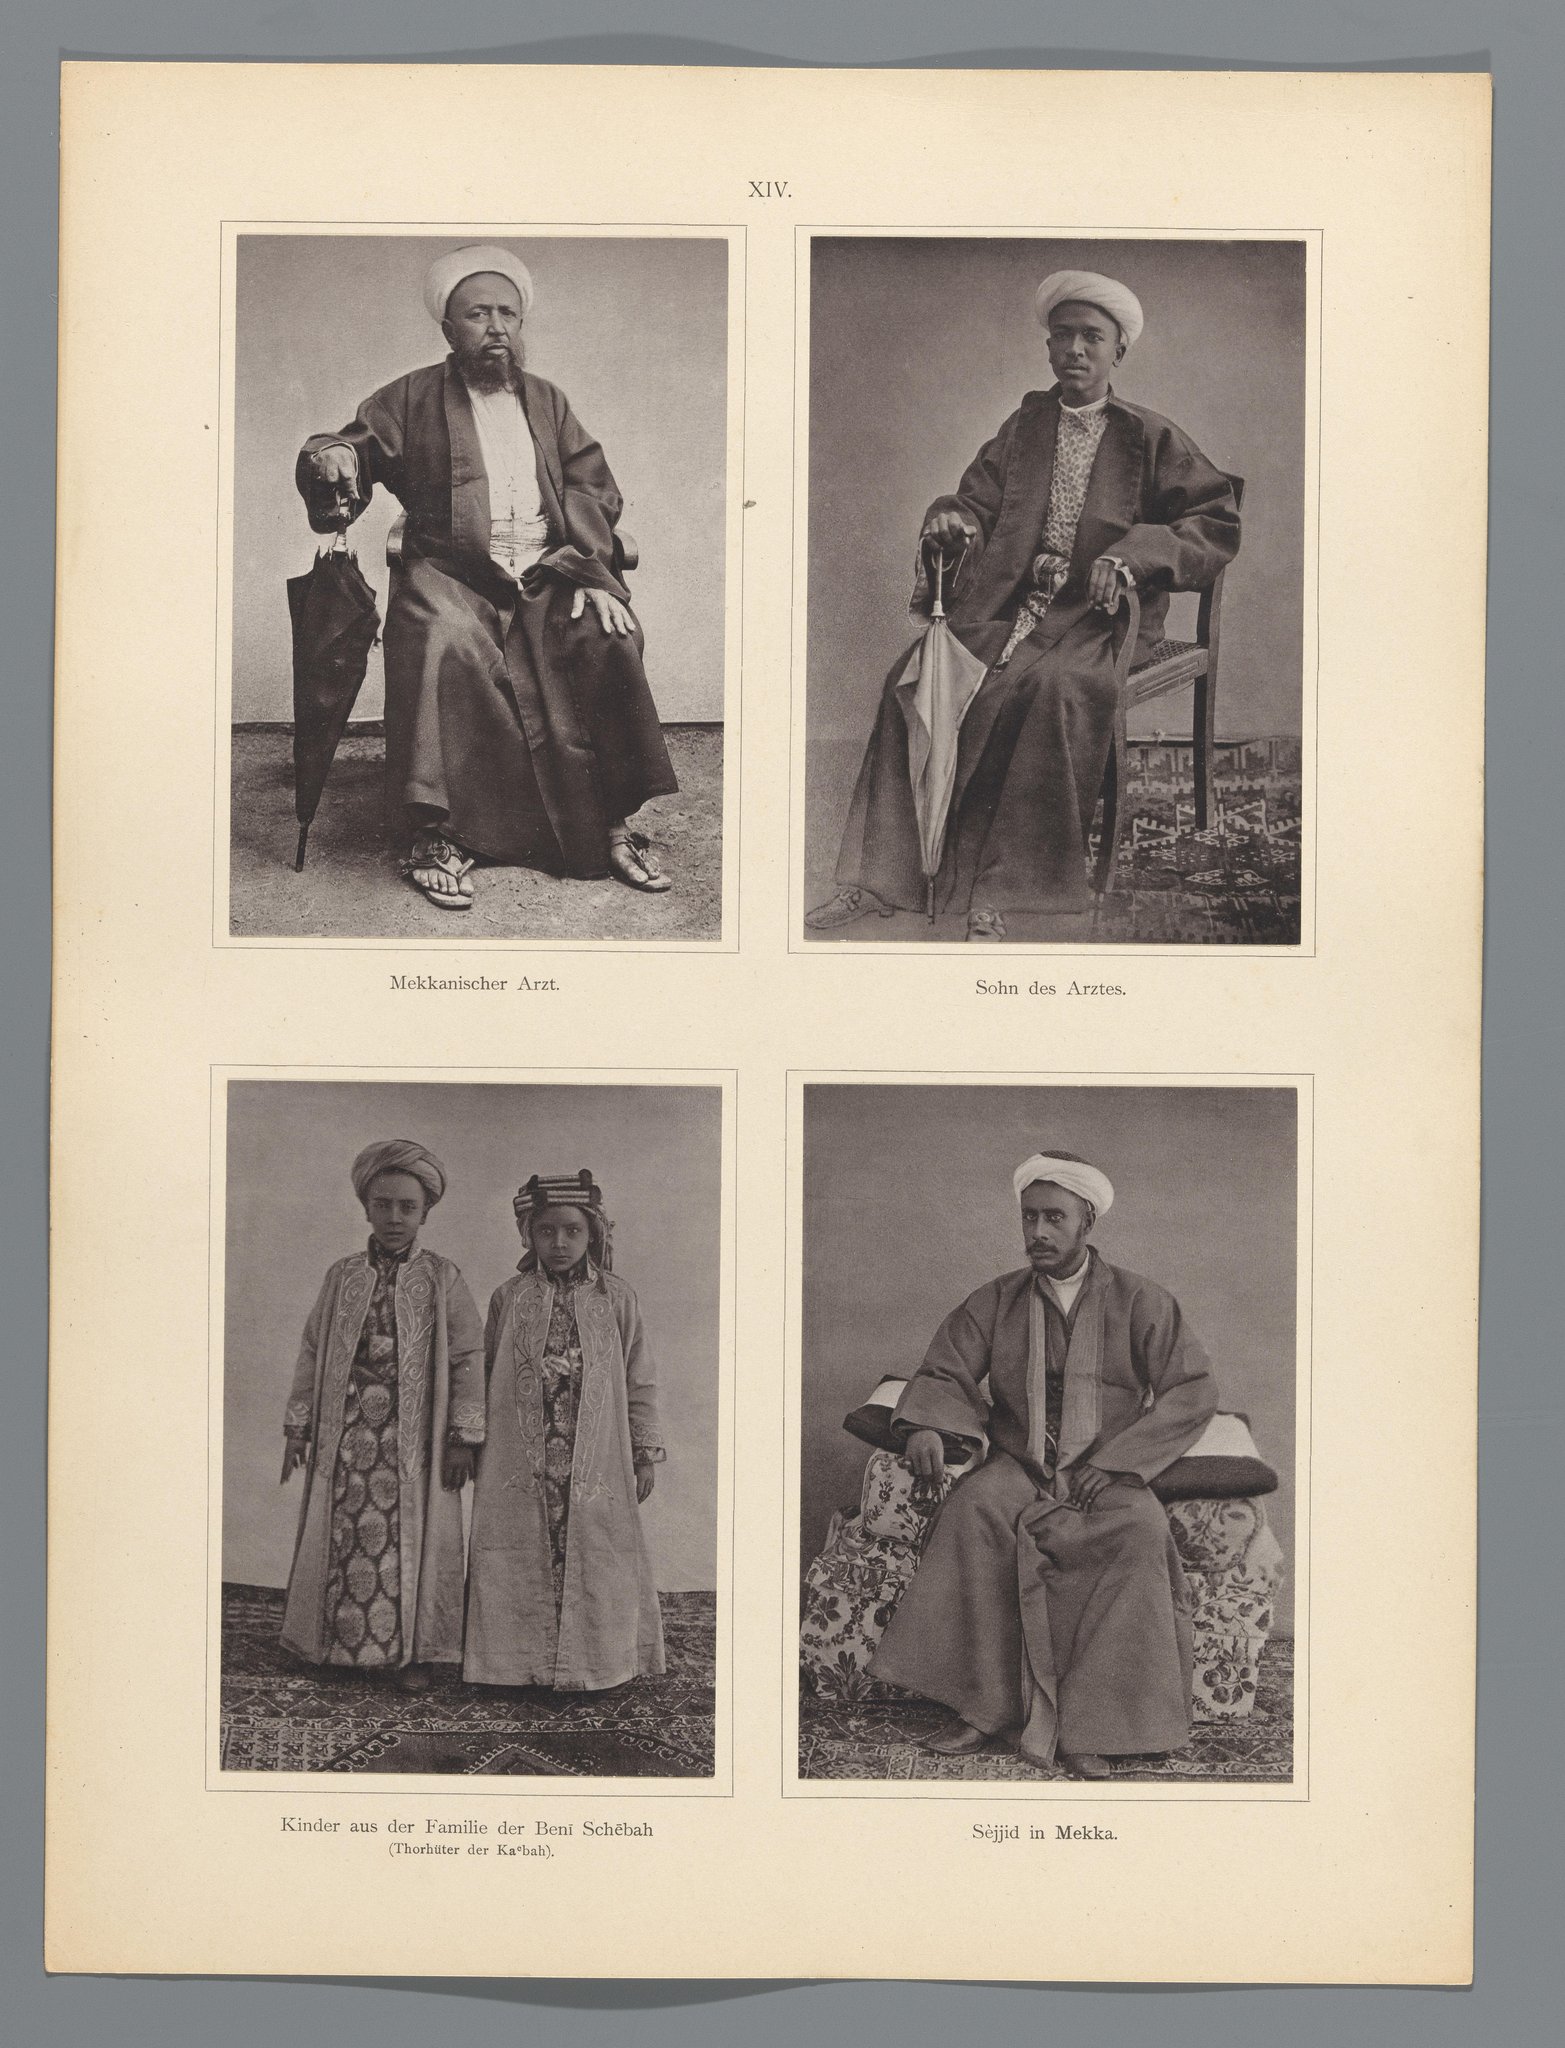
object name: page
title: Mekkanischer Arzt; dessen Sohn; Kinder aus der Familie Schebah; ein Sèjjid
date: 1885-1888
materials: paper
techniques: photograph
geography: mecca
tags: abd al-ghaffar, historical persons (portraits and scenes from the life), historical persons not known by name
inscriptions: number: ‘XIV.’